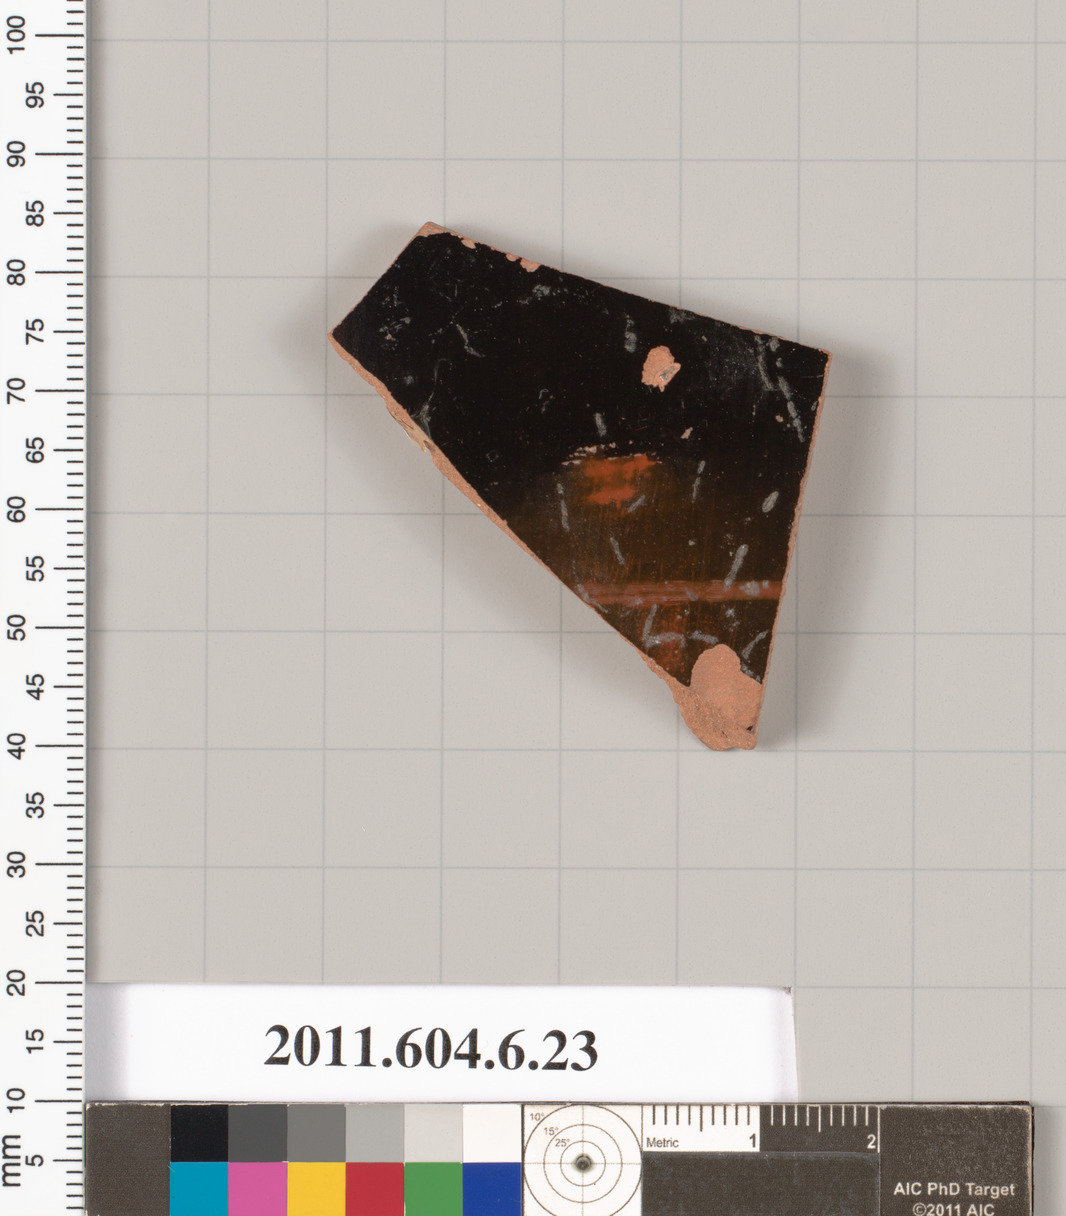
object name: undetermined closed shape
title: Terracotta fragment of a closed shape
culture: greek, attic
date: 600-401 BCE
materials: terracotta